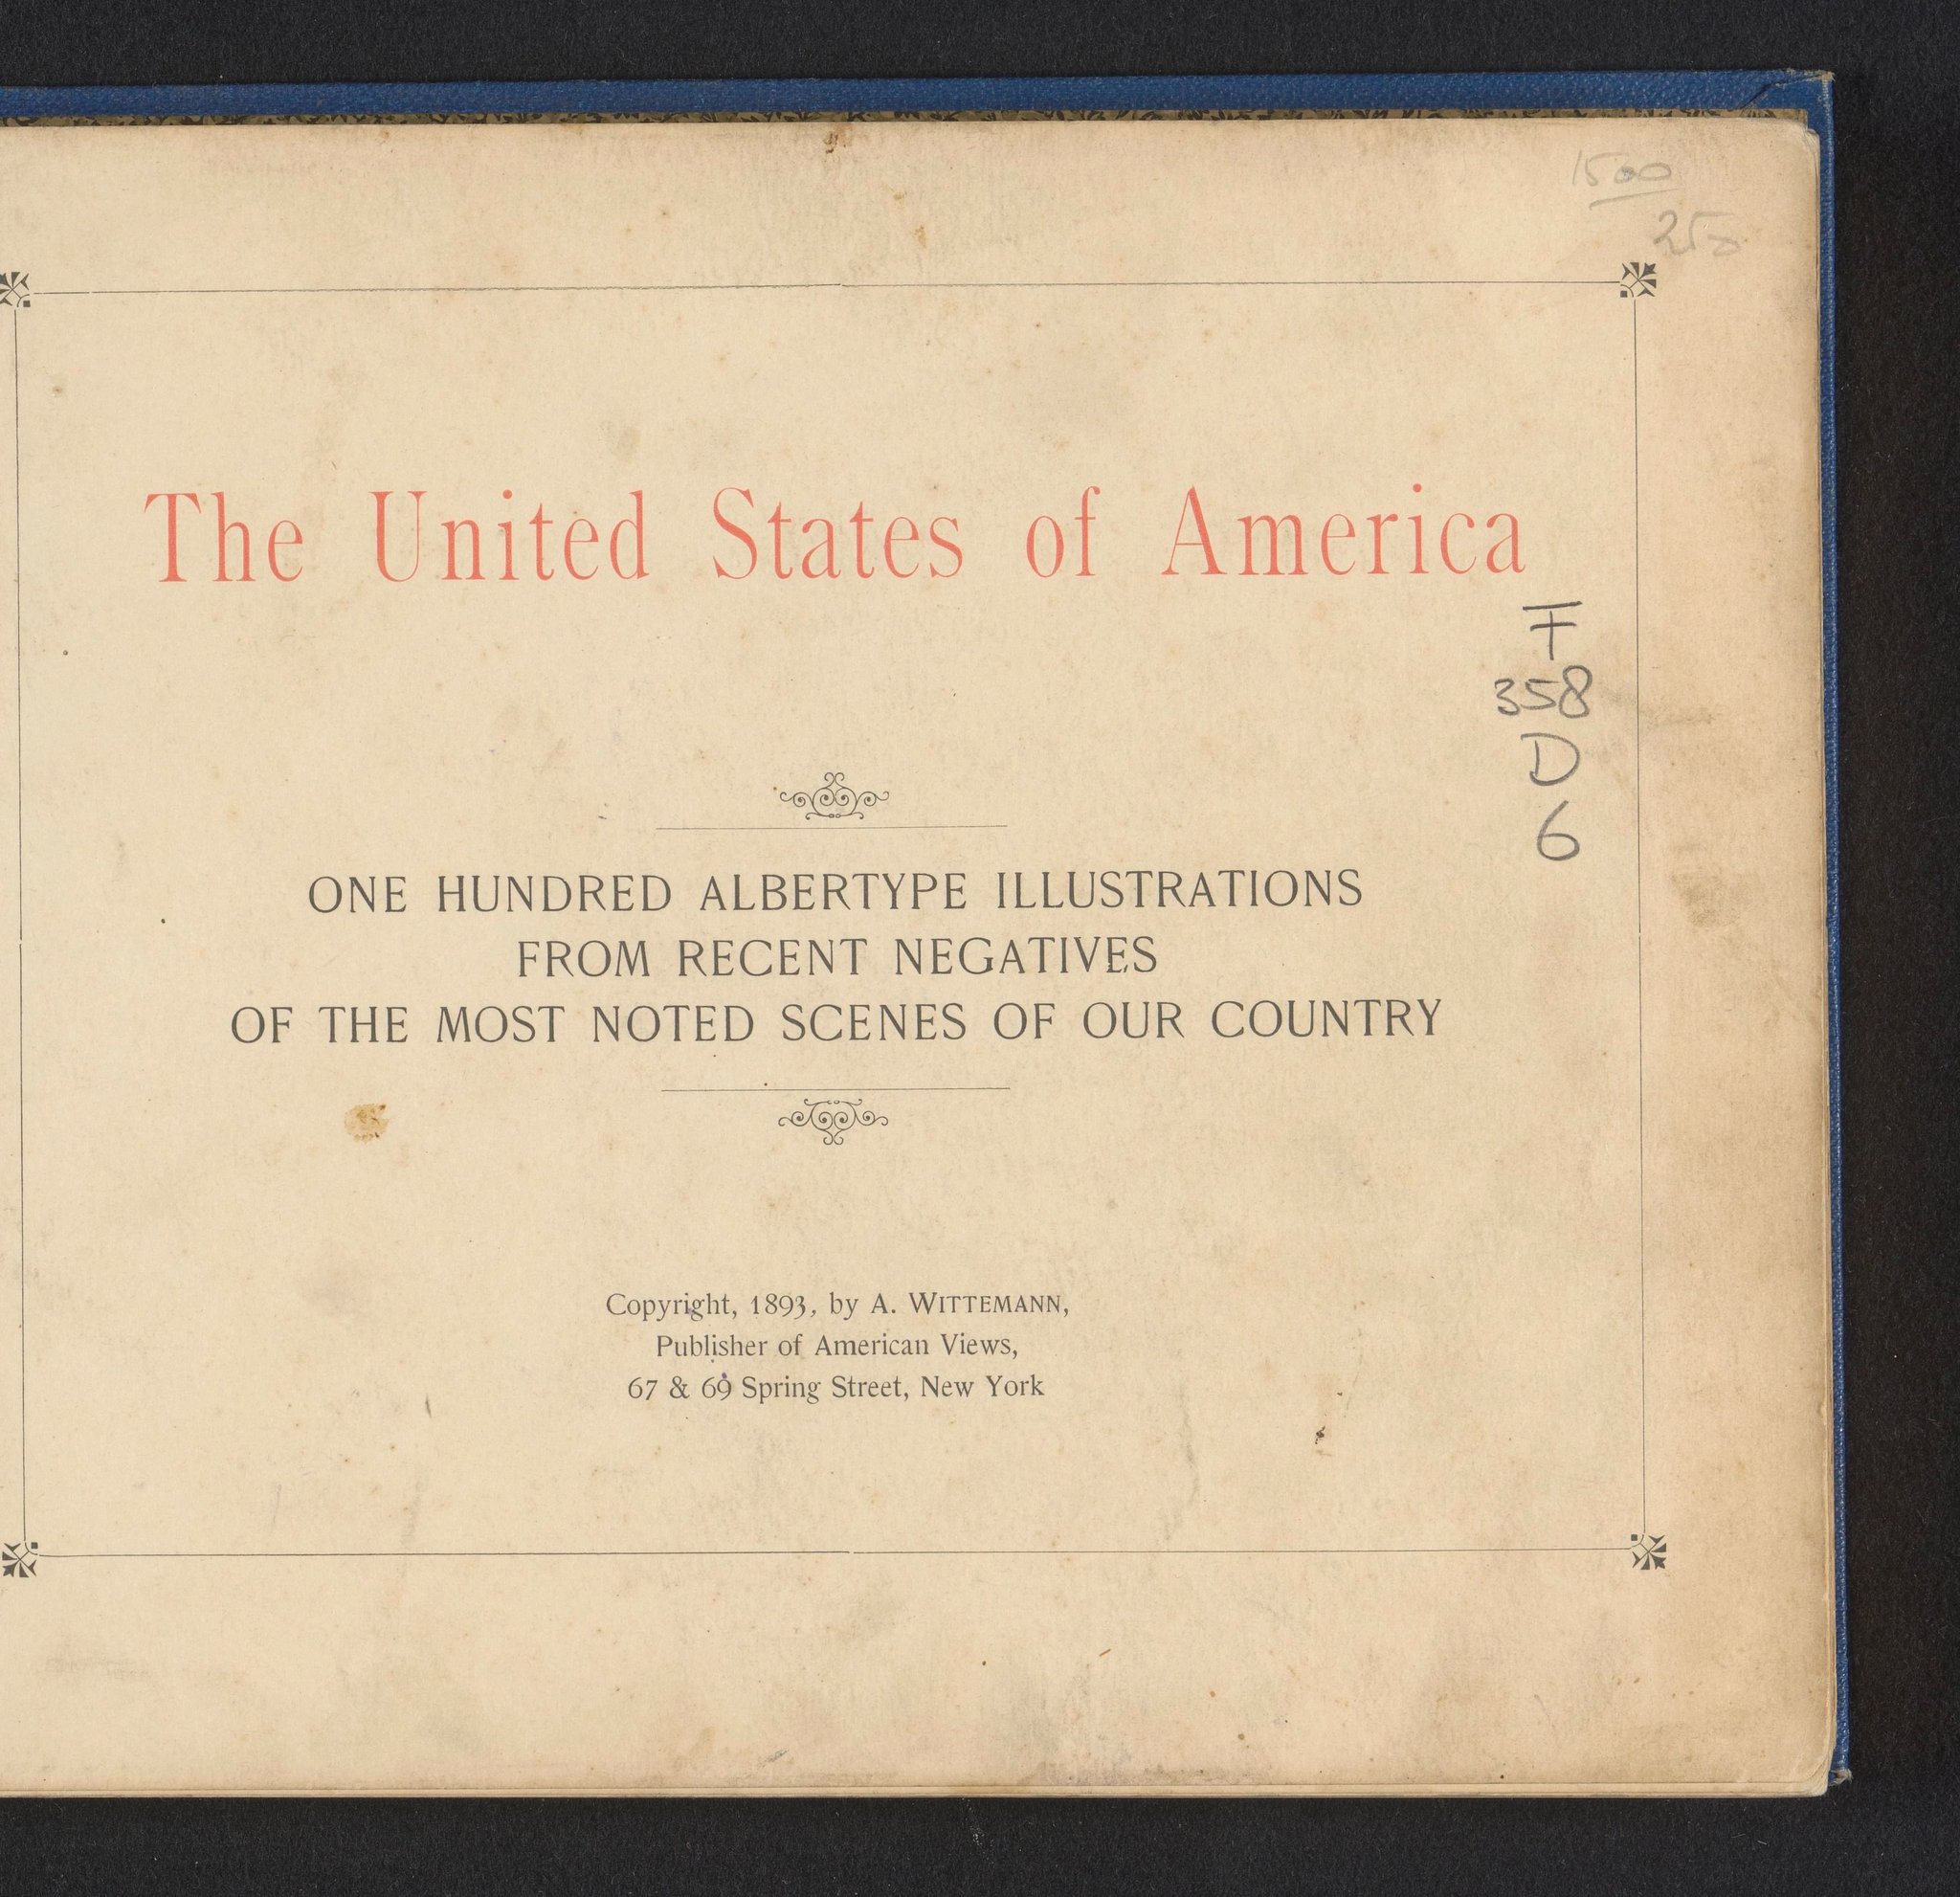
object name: book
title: The United States of America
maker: adolph wittemann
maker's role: publisher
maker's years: 1845-1938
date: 1893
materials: cardboard, linen, paper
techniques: photograph, decorated paper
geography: new york city